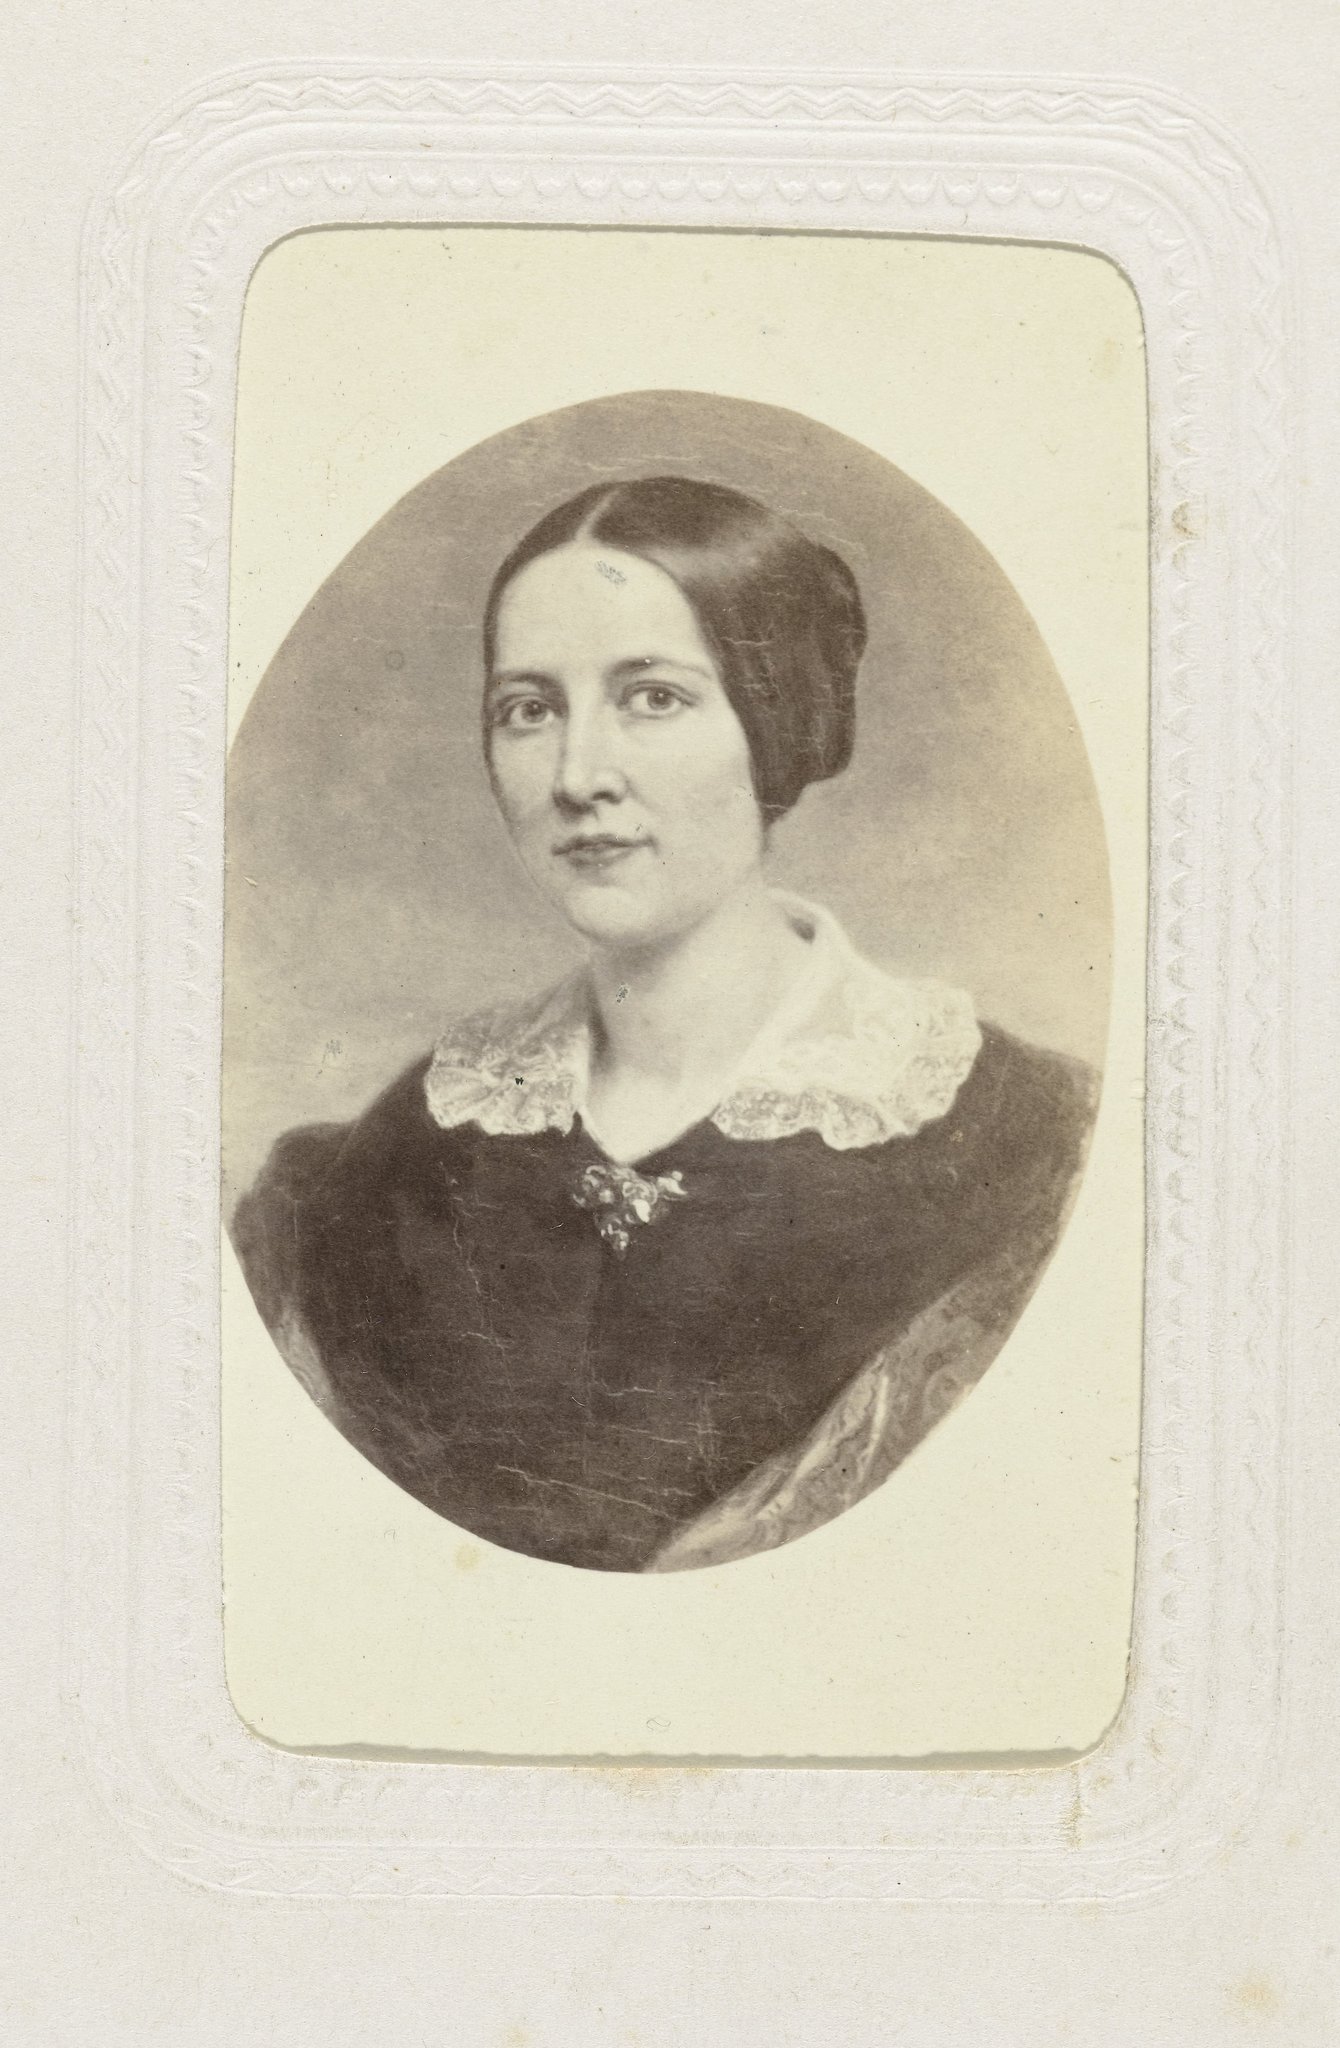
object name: carte de visite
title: Geschilderd ovaal portret van een vrouw met opgestoken haar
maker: carl rensing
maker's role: fotograaf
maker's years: 1826-1898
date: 1863-1870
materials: cardboard, paper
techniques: albumen print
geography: amsterdam